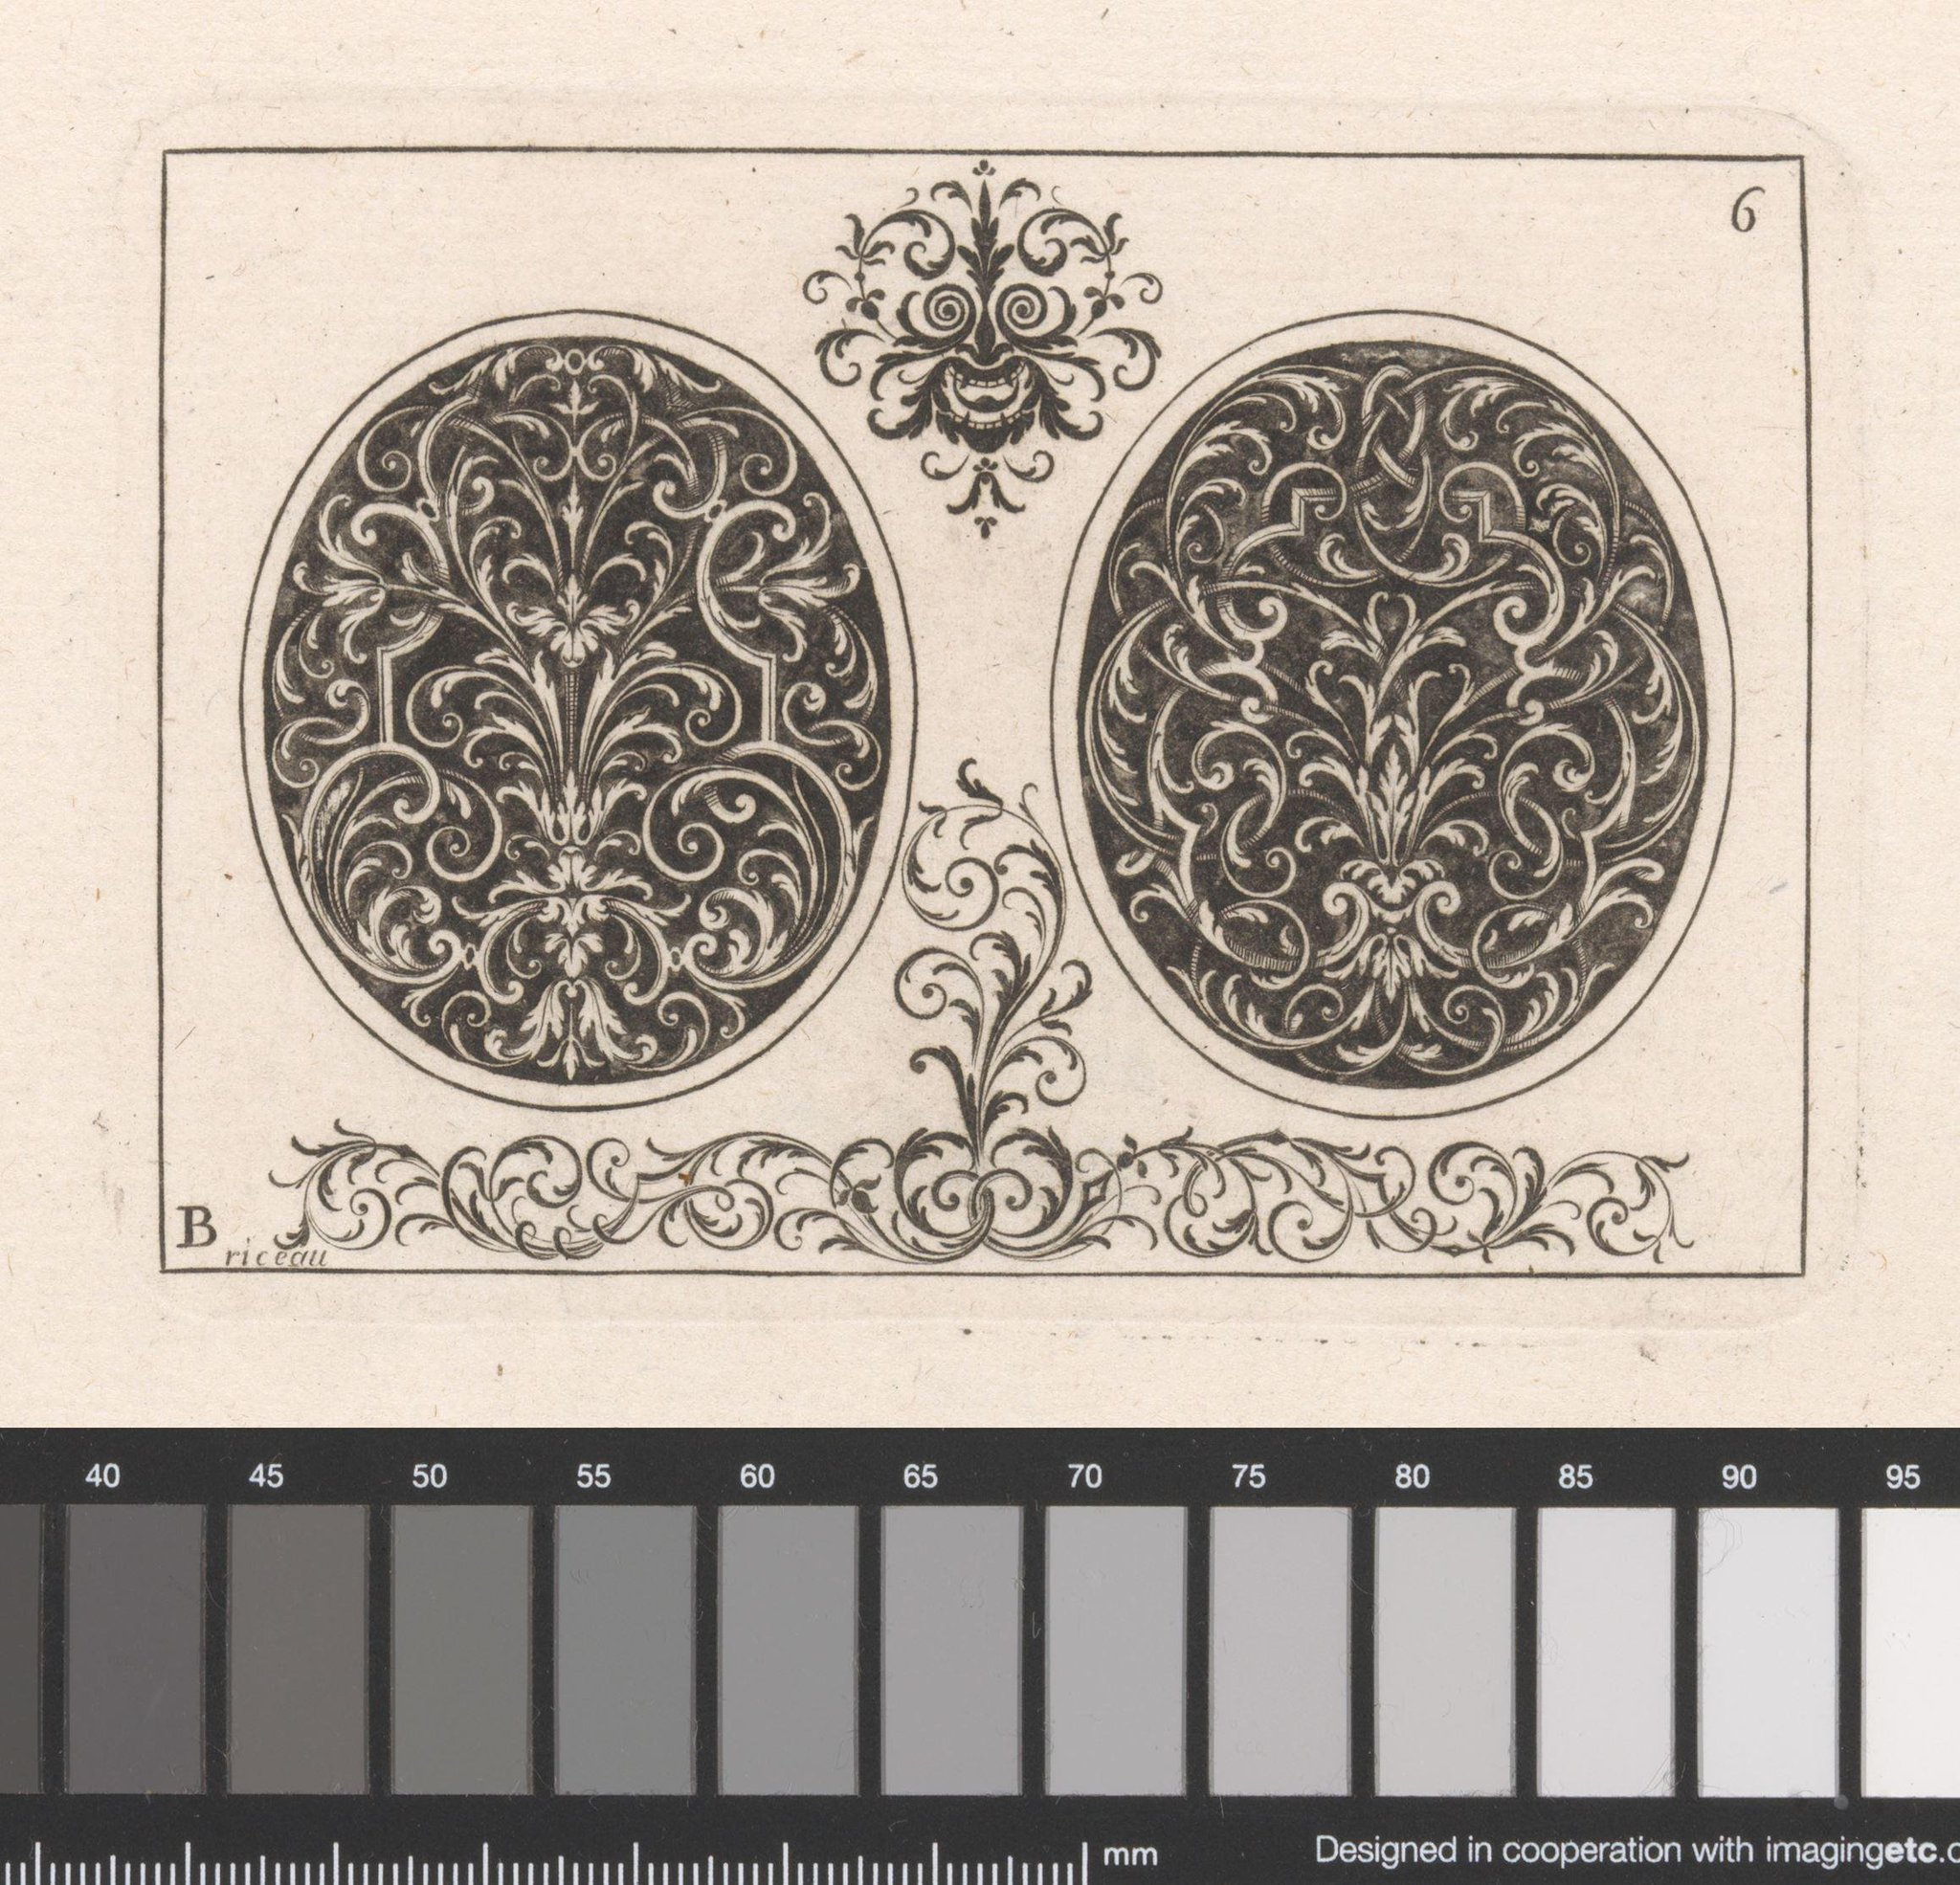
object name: print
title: Twee medaillons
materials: paper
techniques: etching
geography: paris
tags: interlace ~ ornament, ornament ~ medallion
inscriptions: collector's mark: Lugt 2228, collector's mark: Lugt 2166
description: Twee ovale medaillons gevuld met vlechtwerk. Boven en onder twee ornamenten.